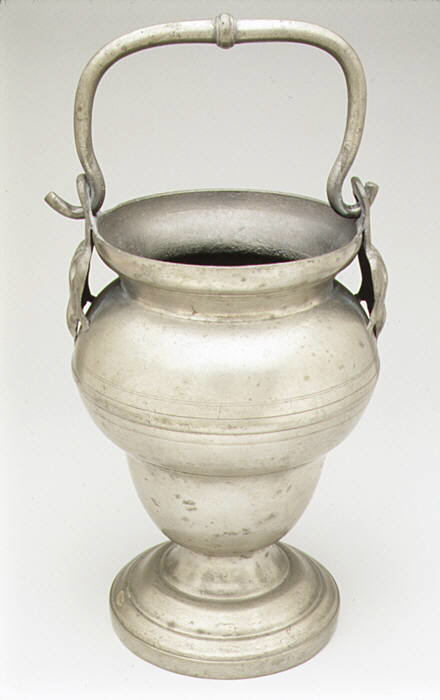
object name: holy water vessel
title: Holy-water vessel (Aspersorium)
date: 1701-1800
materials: pewter